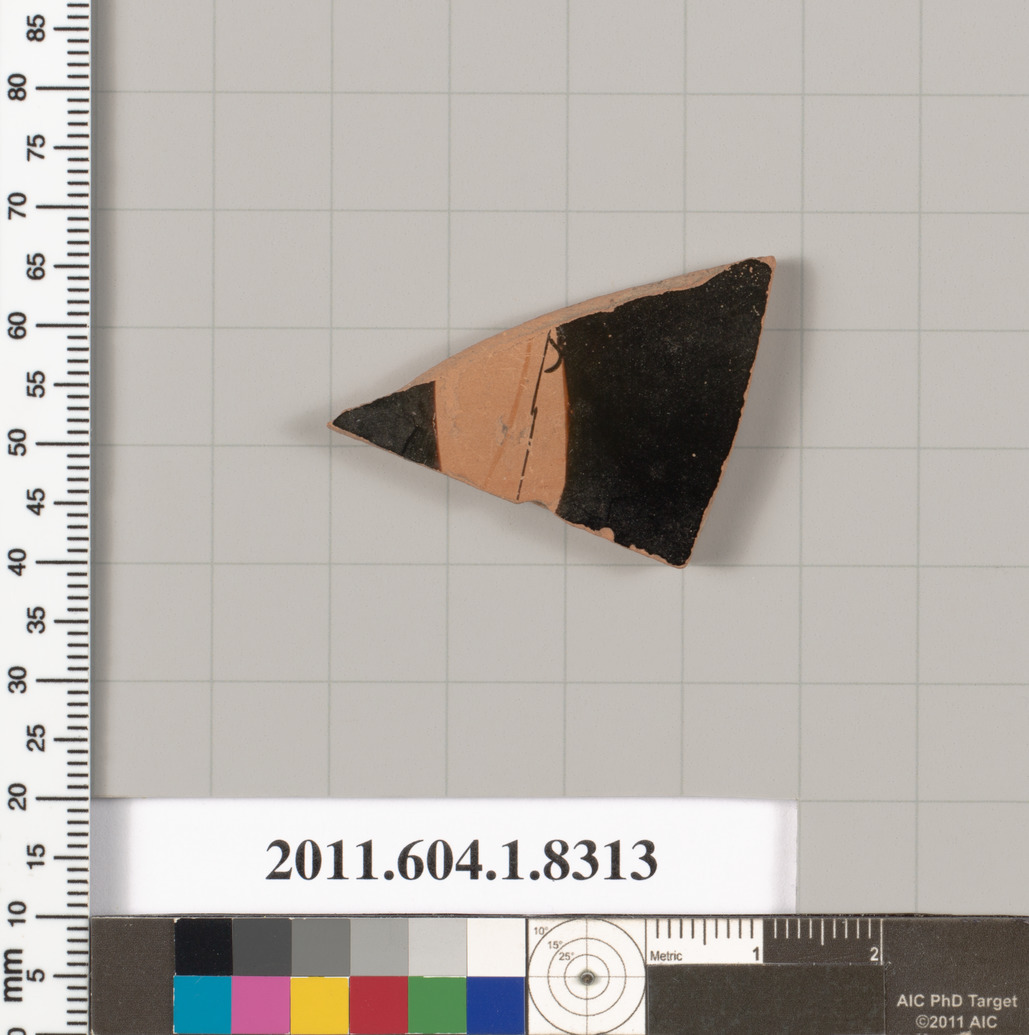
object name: kylix fragment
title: Terracotta fragment of a kylix (drinking cup)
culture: greek, attic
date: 425-401 BCE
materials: terracotta